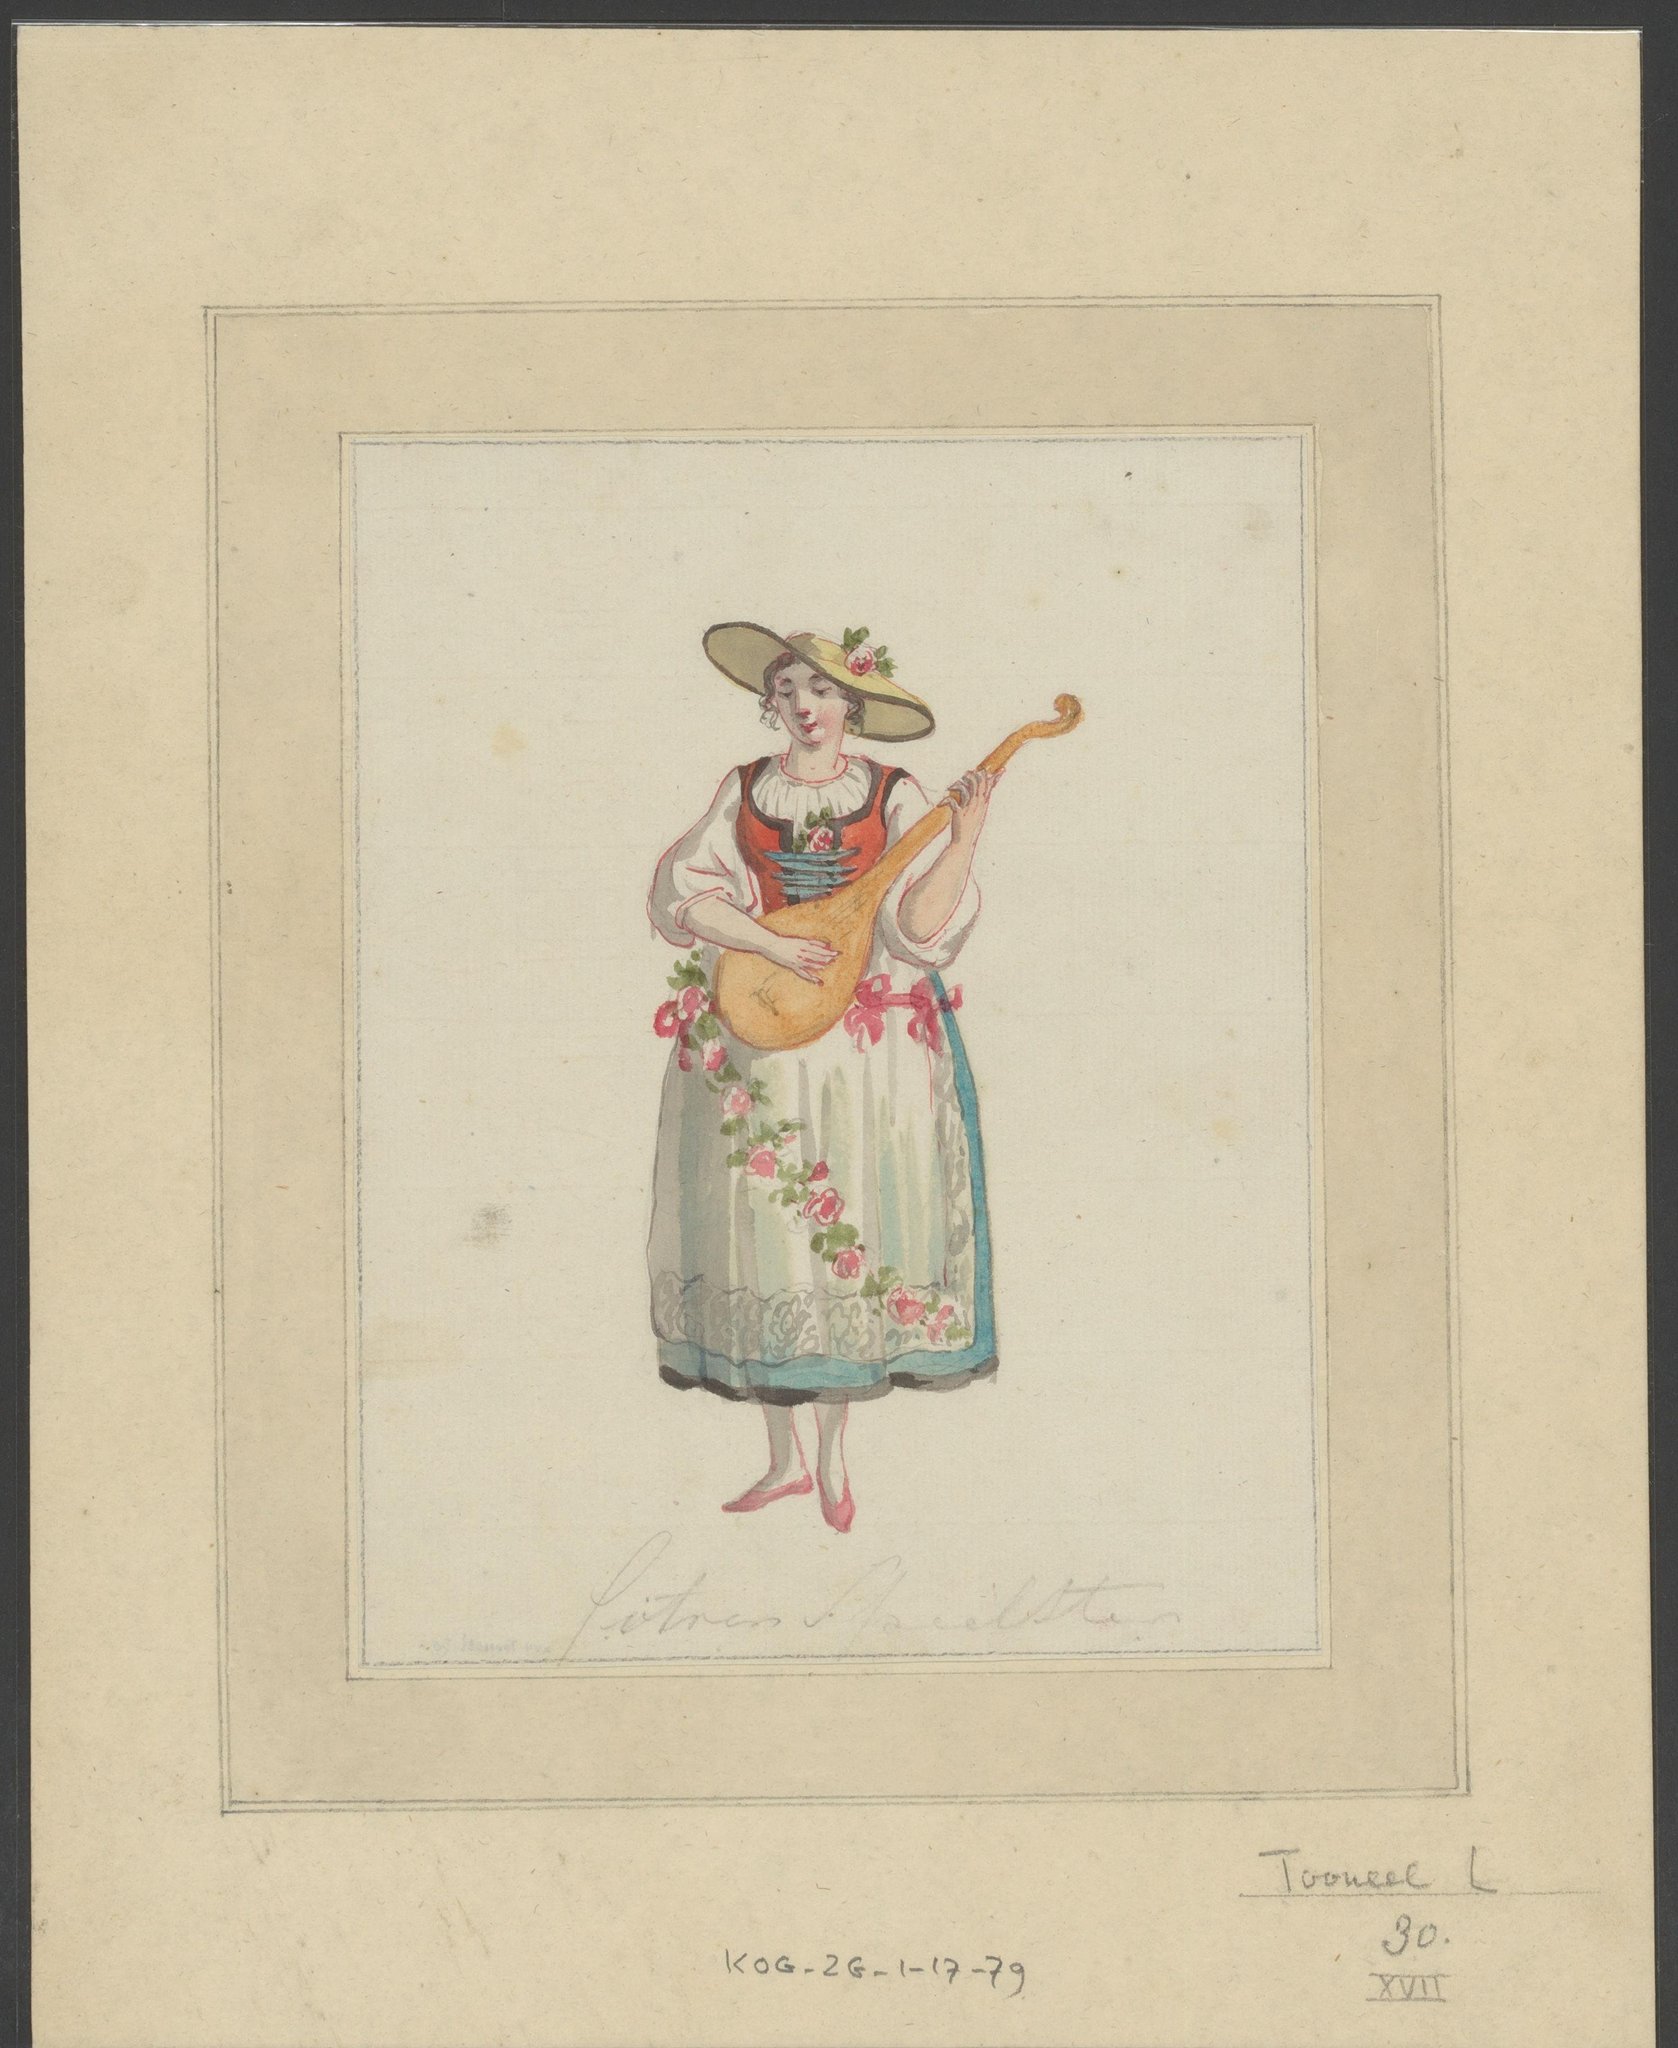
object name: drawing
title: Theaterkostuum voor een citerspeelster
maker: Anonymous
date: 1800-1825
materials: ink, paper, watercolor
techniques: brush, pen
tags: stage costume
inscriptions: collector's mark: Lugt 1641, stamp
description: Onderwerpsrubrieken binnen de Atlas Zeden en Gewoonten: Tooneel, Ontwerpen costumes.